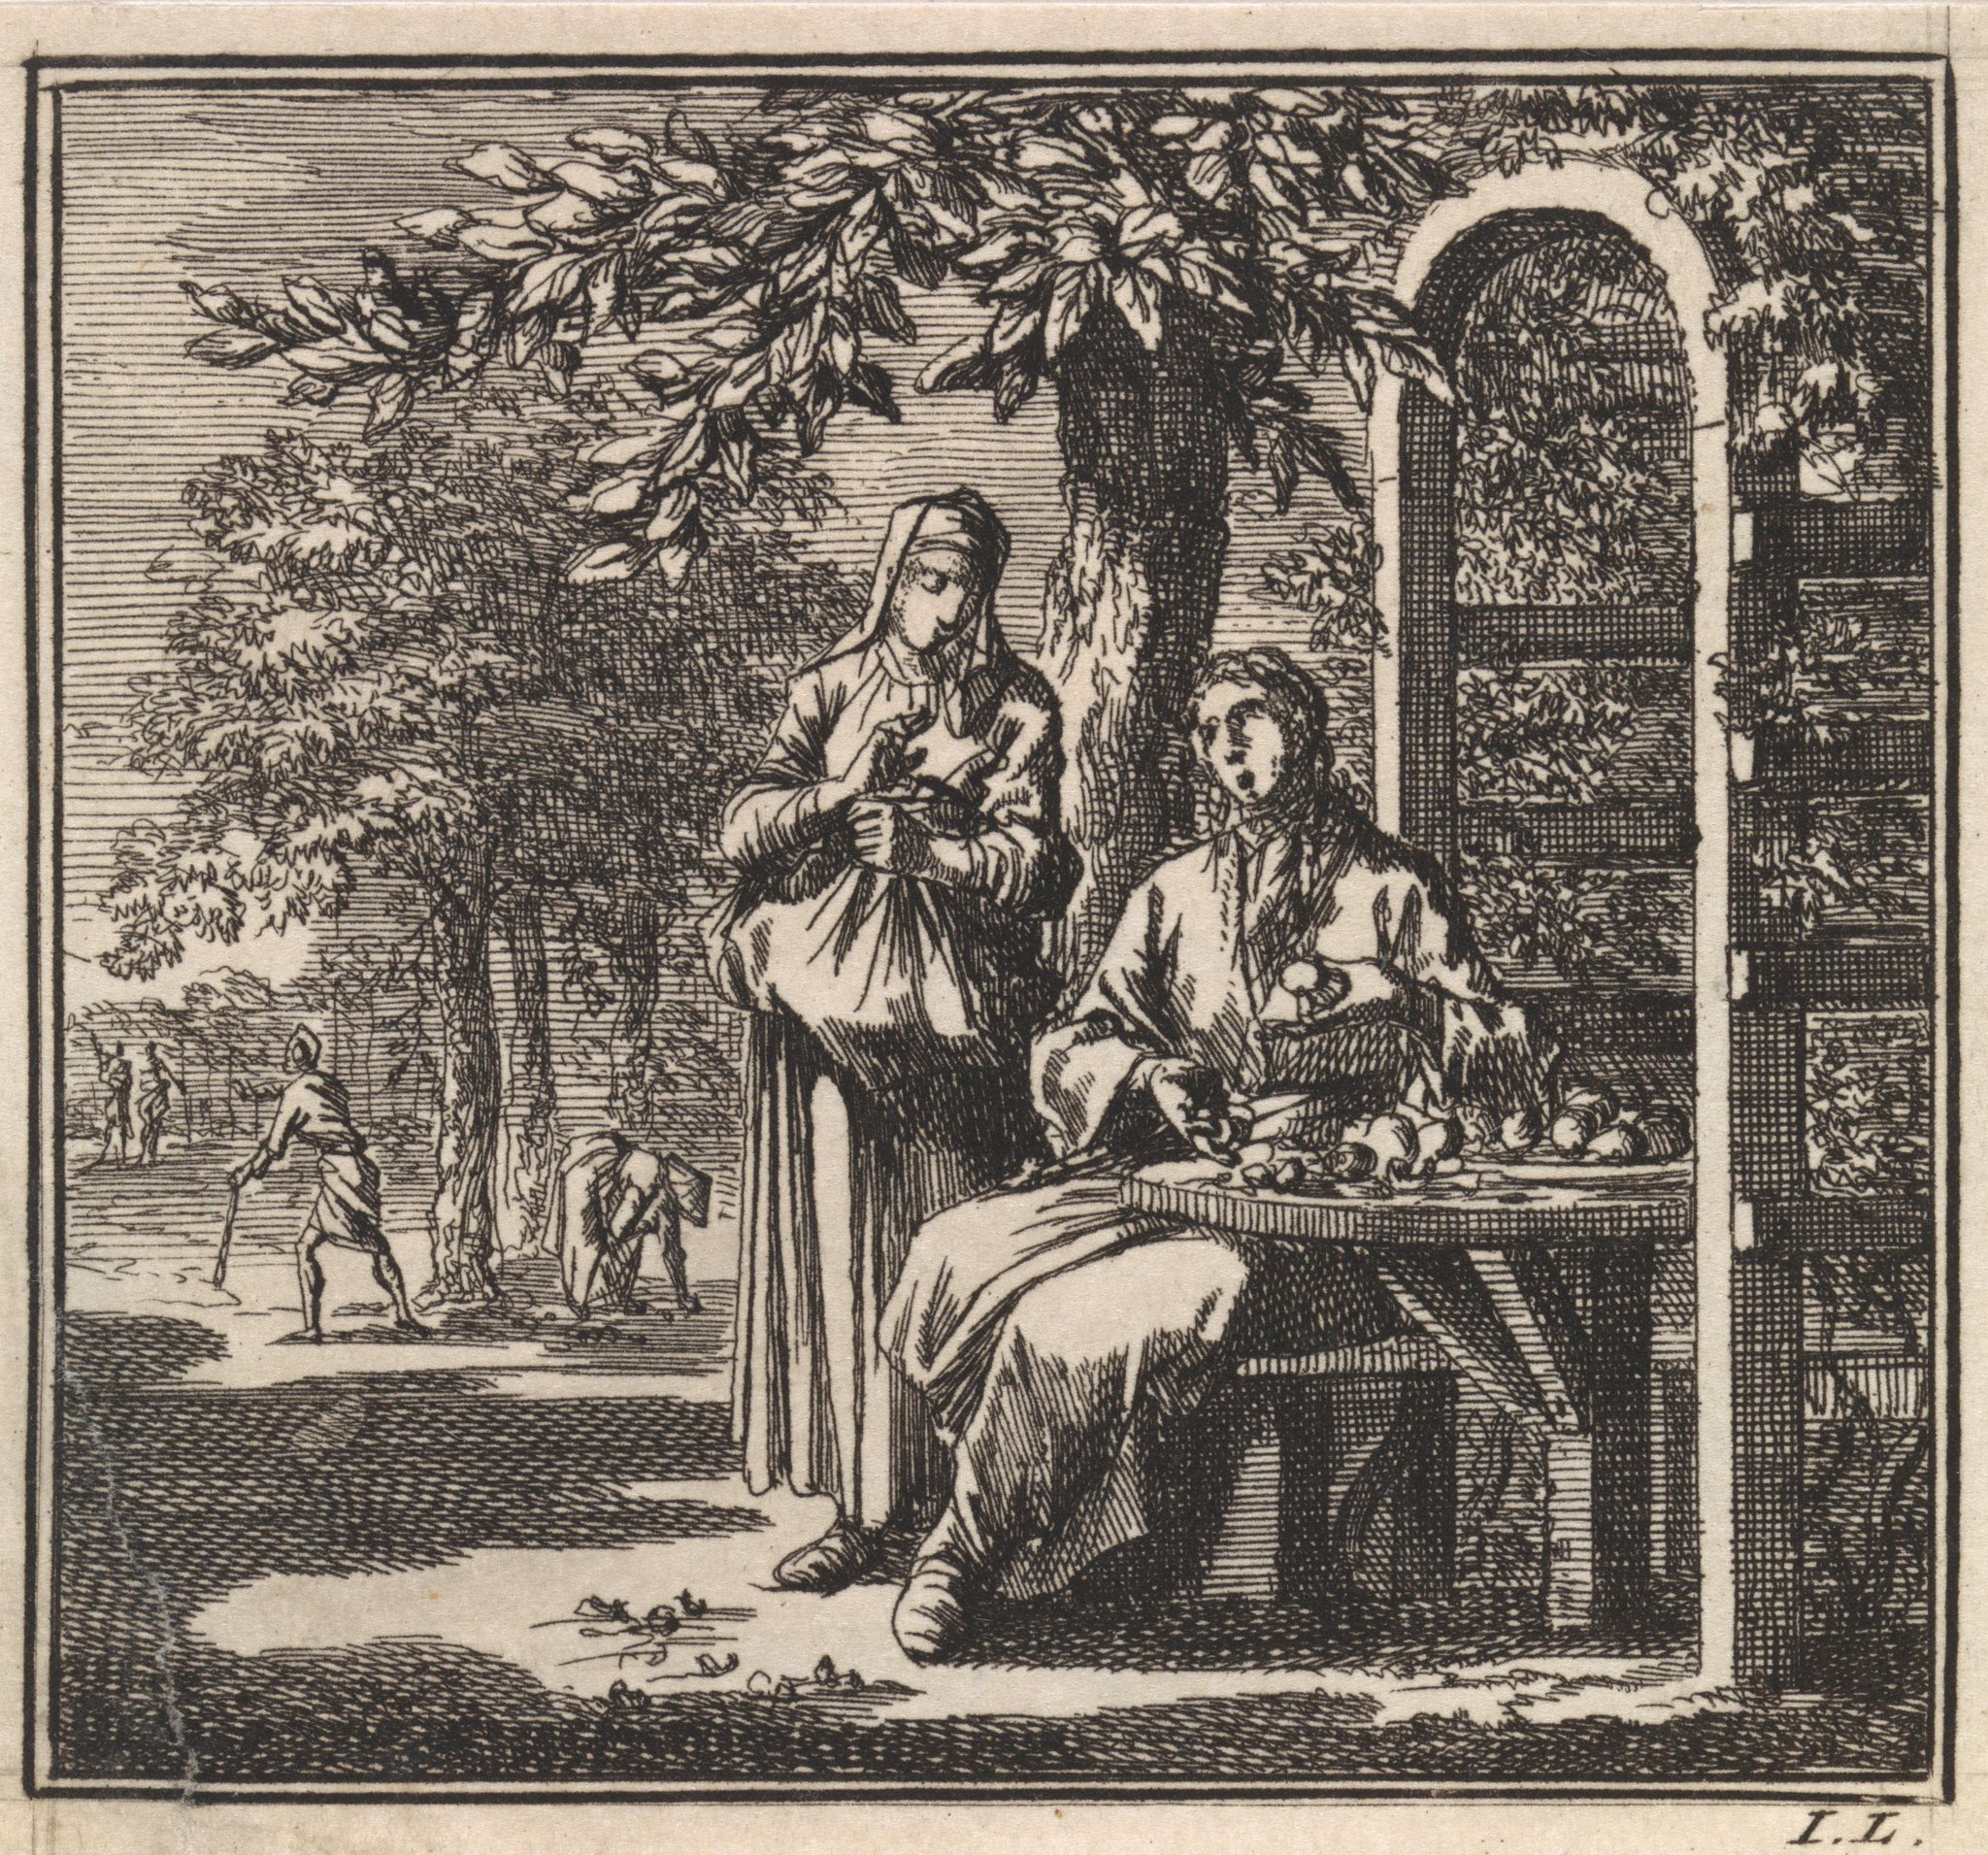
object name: book illustration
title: De Noot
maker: jan luyken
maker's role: draughtsman, print maker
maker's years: 1649-1712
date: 1711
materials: paper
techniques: etching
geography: amsterdam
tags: fruits: nuts, garden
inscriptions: collector's mark: Lugt 2228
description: Illustratie voor: Luyken, Jan. De Bykorf des Gemoeds. Amsterdam: Pieter Arentsz. II (wed.) en Cornelis van der Sys, 1711, p. 58.